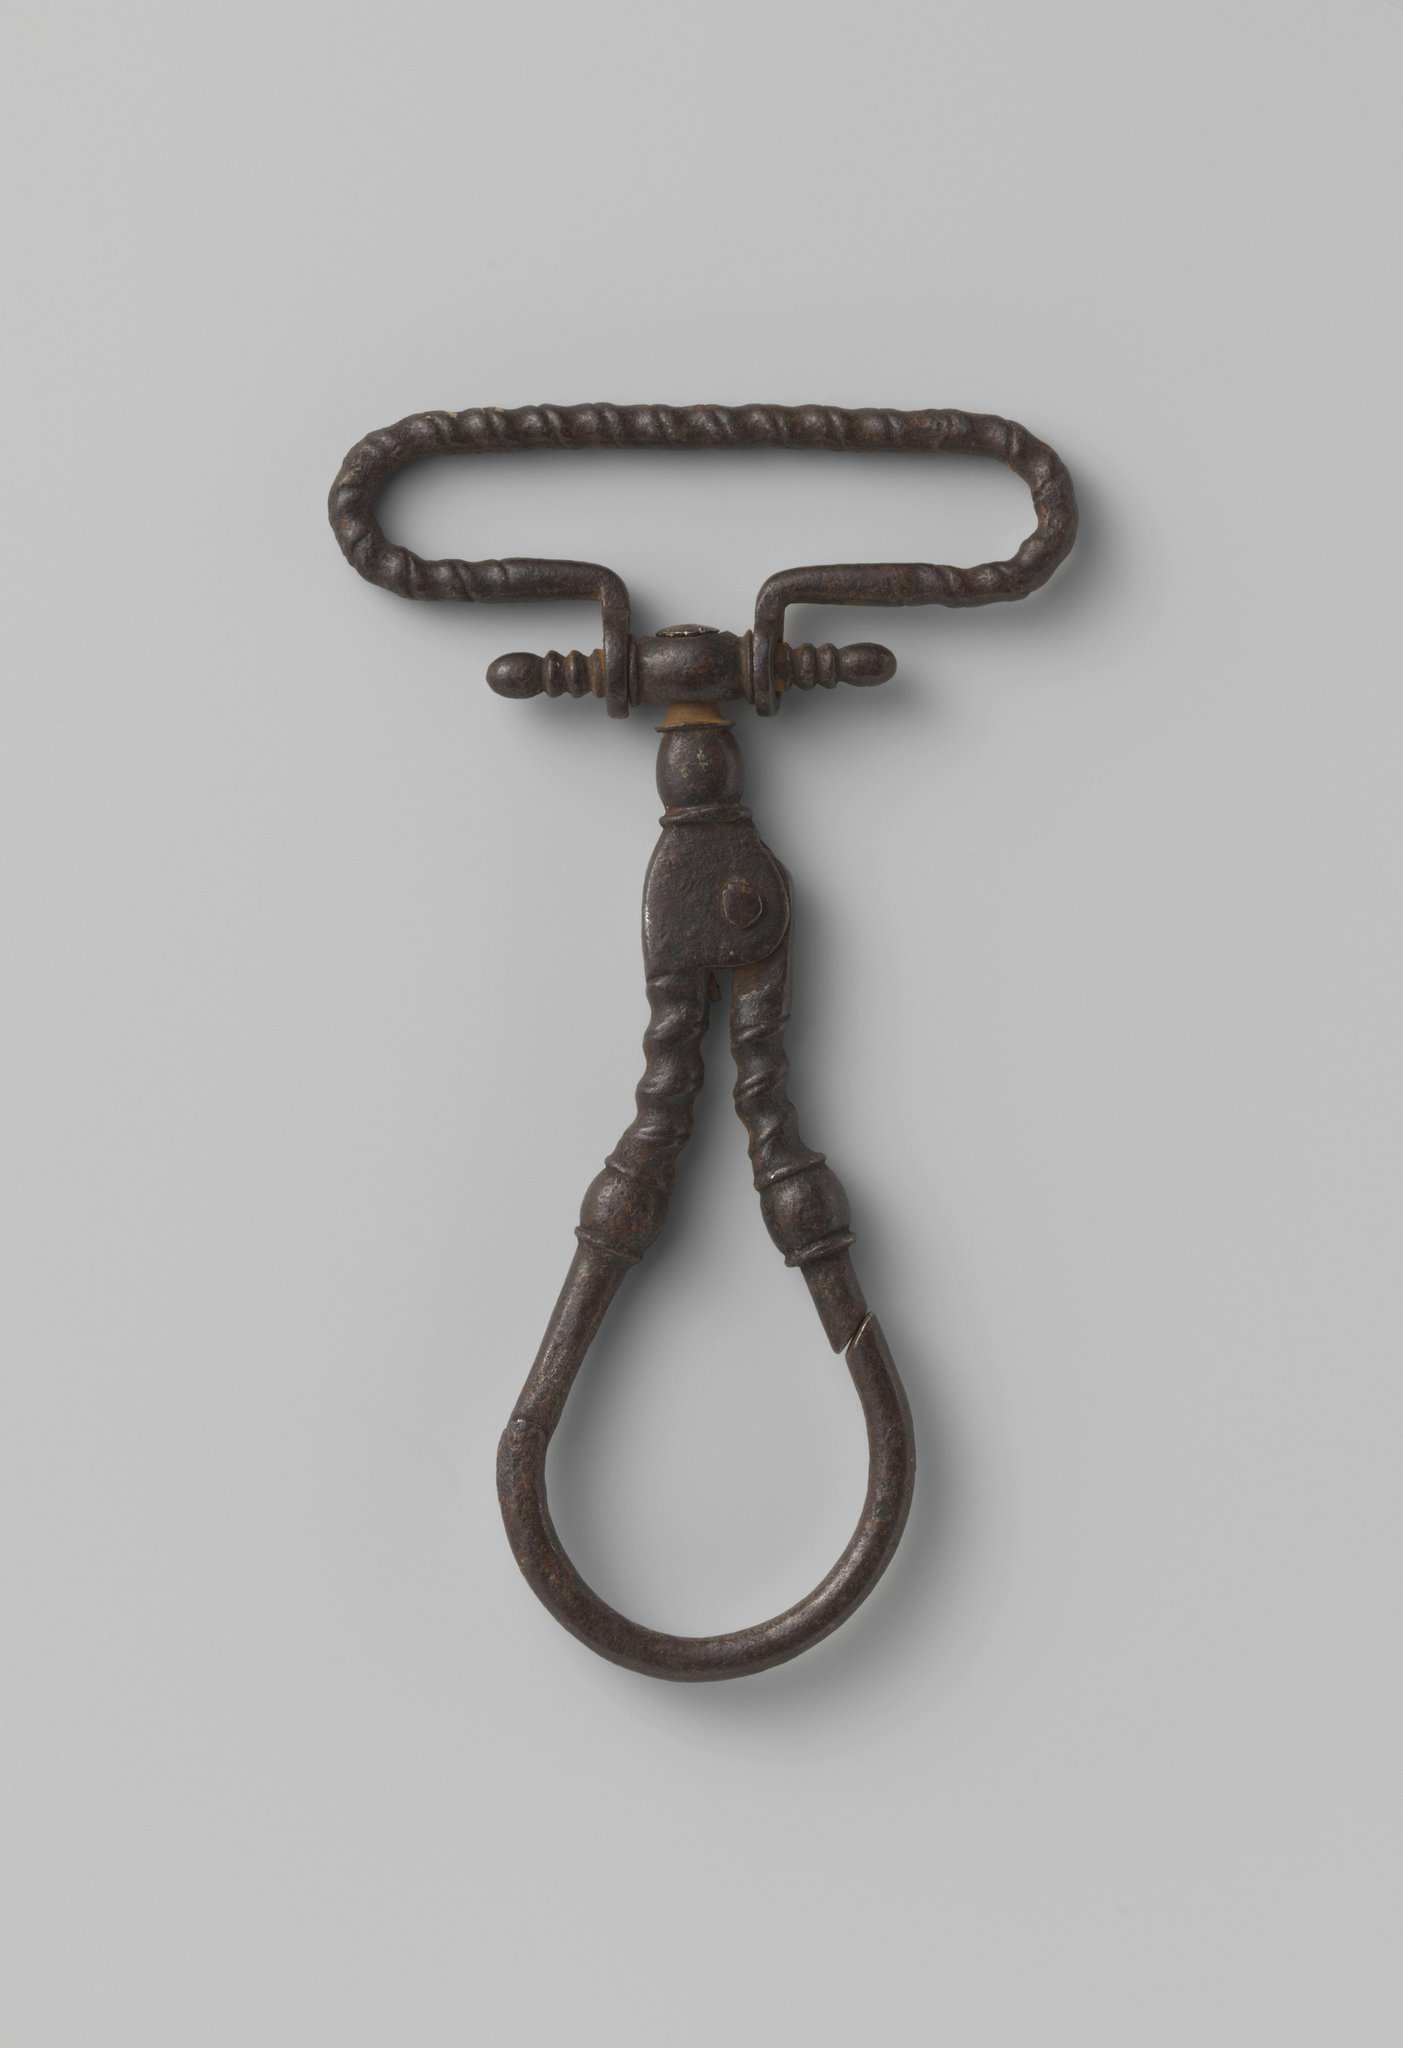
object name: key ring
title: Sleutelring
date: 1600-1699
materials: iron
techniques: torsion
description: Een sleutelring bestaande uit twee delen n.l. een gleufvormige draagring en de eigenlijke sleutelring, die peervormig is. Zij worden verbonden door een spilvormig scharnier. De draagring en bovengedeelte van de sleutelring zijn getorst.